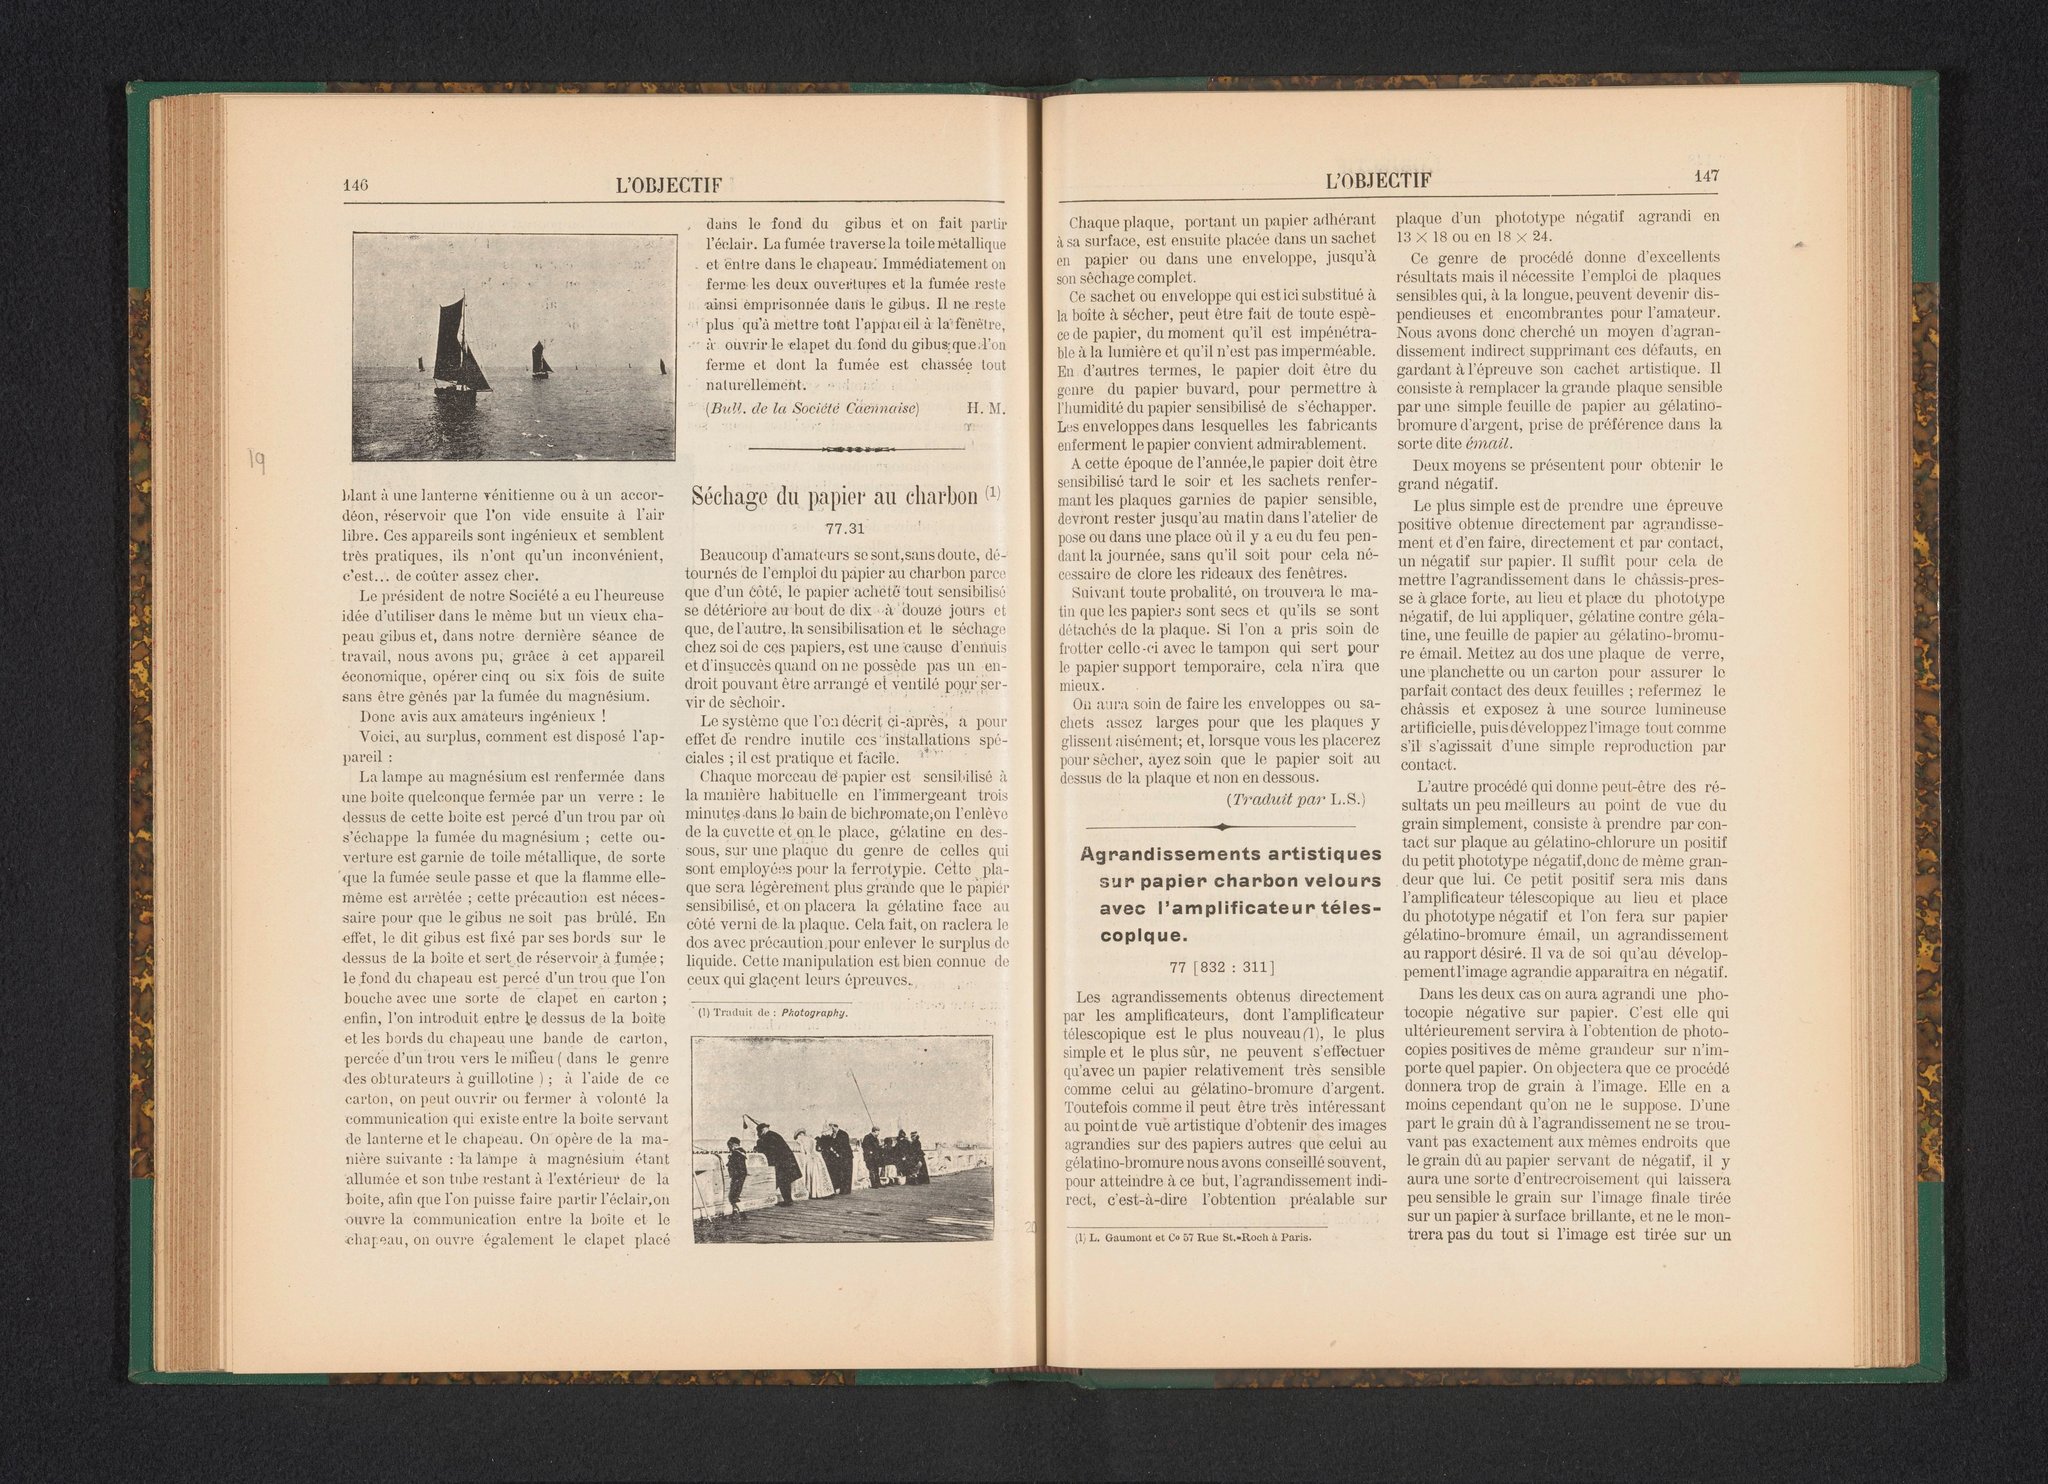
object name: photomechanical print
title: Zeilboten op zee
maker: Anonymous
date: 1896-1900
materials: paper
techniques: autotype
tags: sailing-ship, sailing-boat, sea